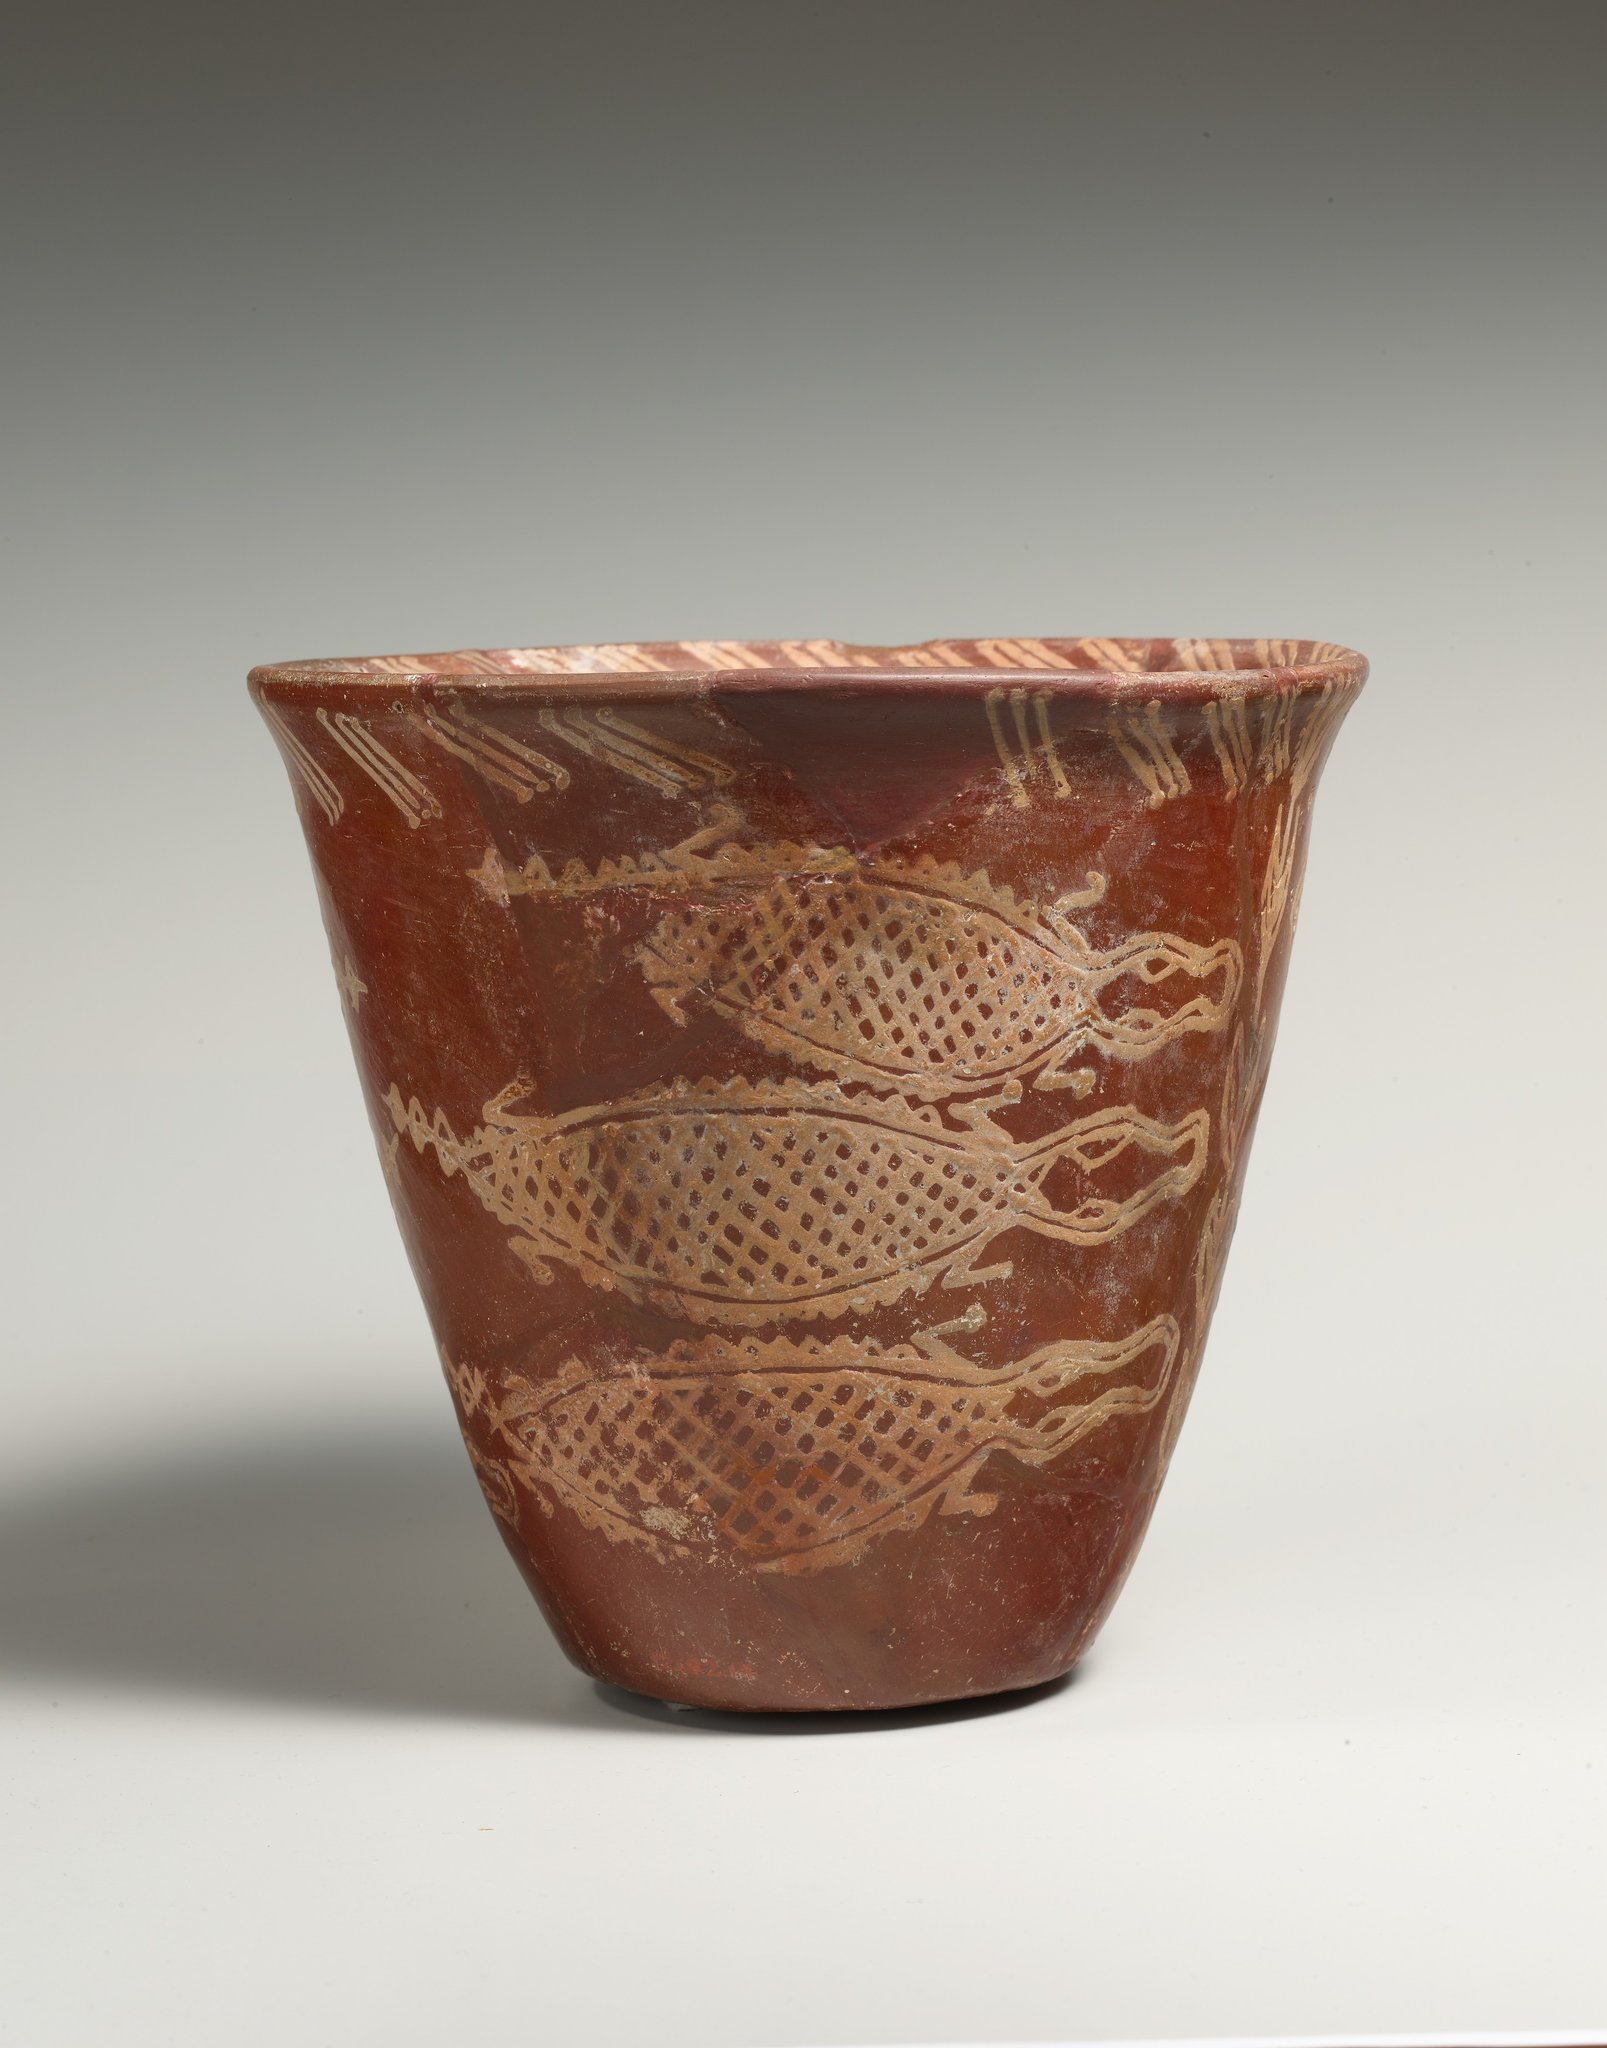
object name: beaker, white cross lined ware, nile river scene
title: White cross-lined ware beaker with Nile River scene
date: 3650-3500 BCE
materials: paint, pottery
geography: egypt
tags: animals